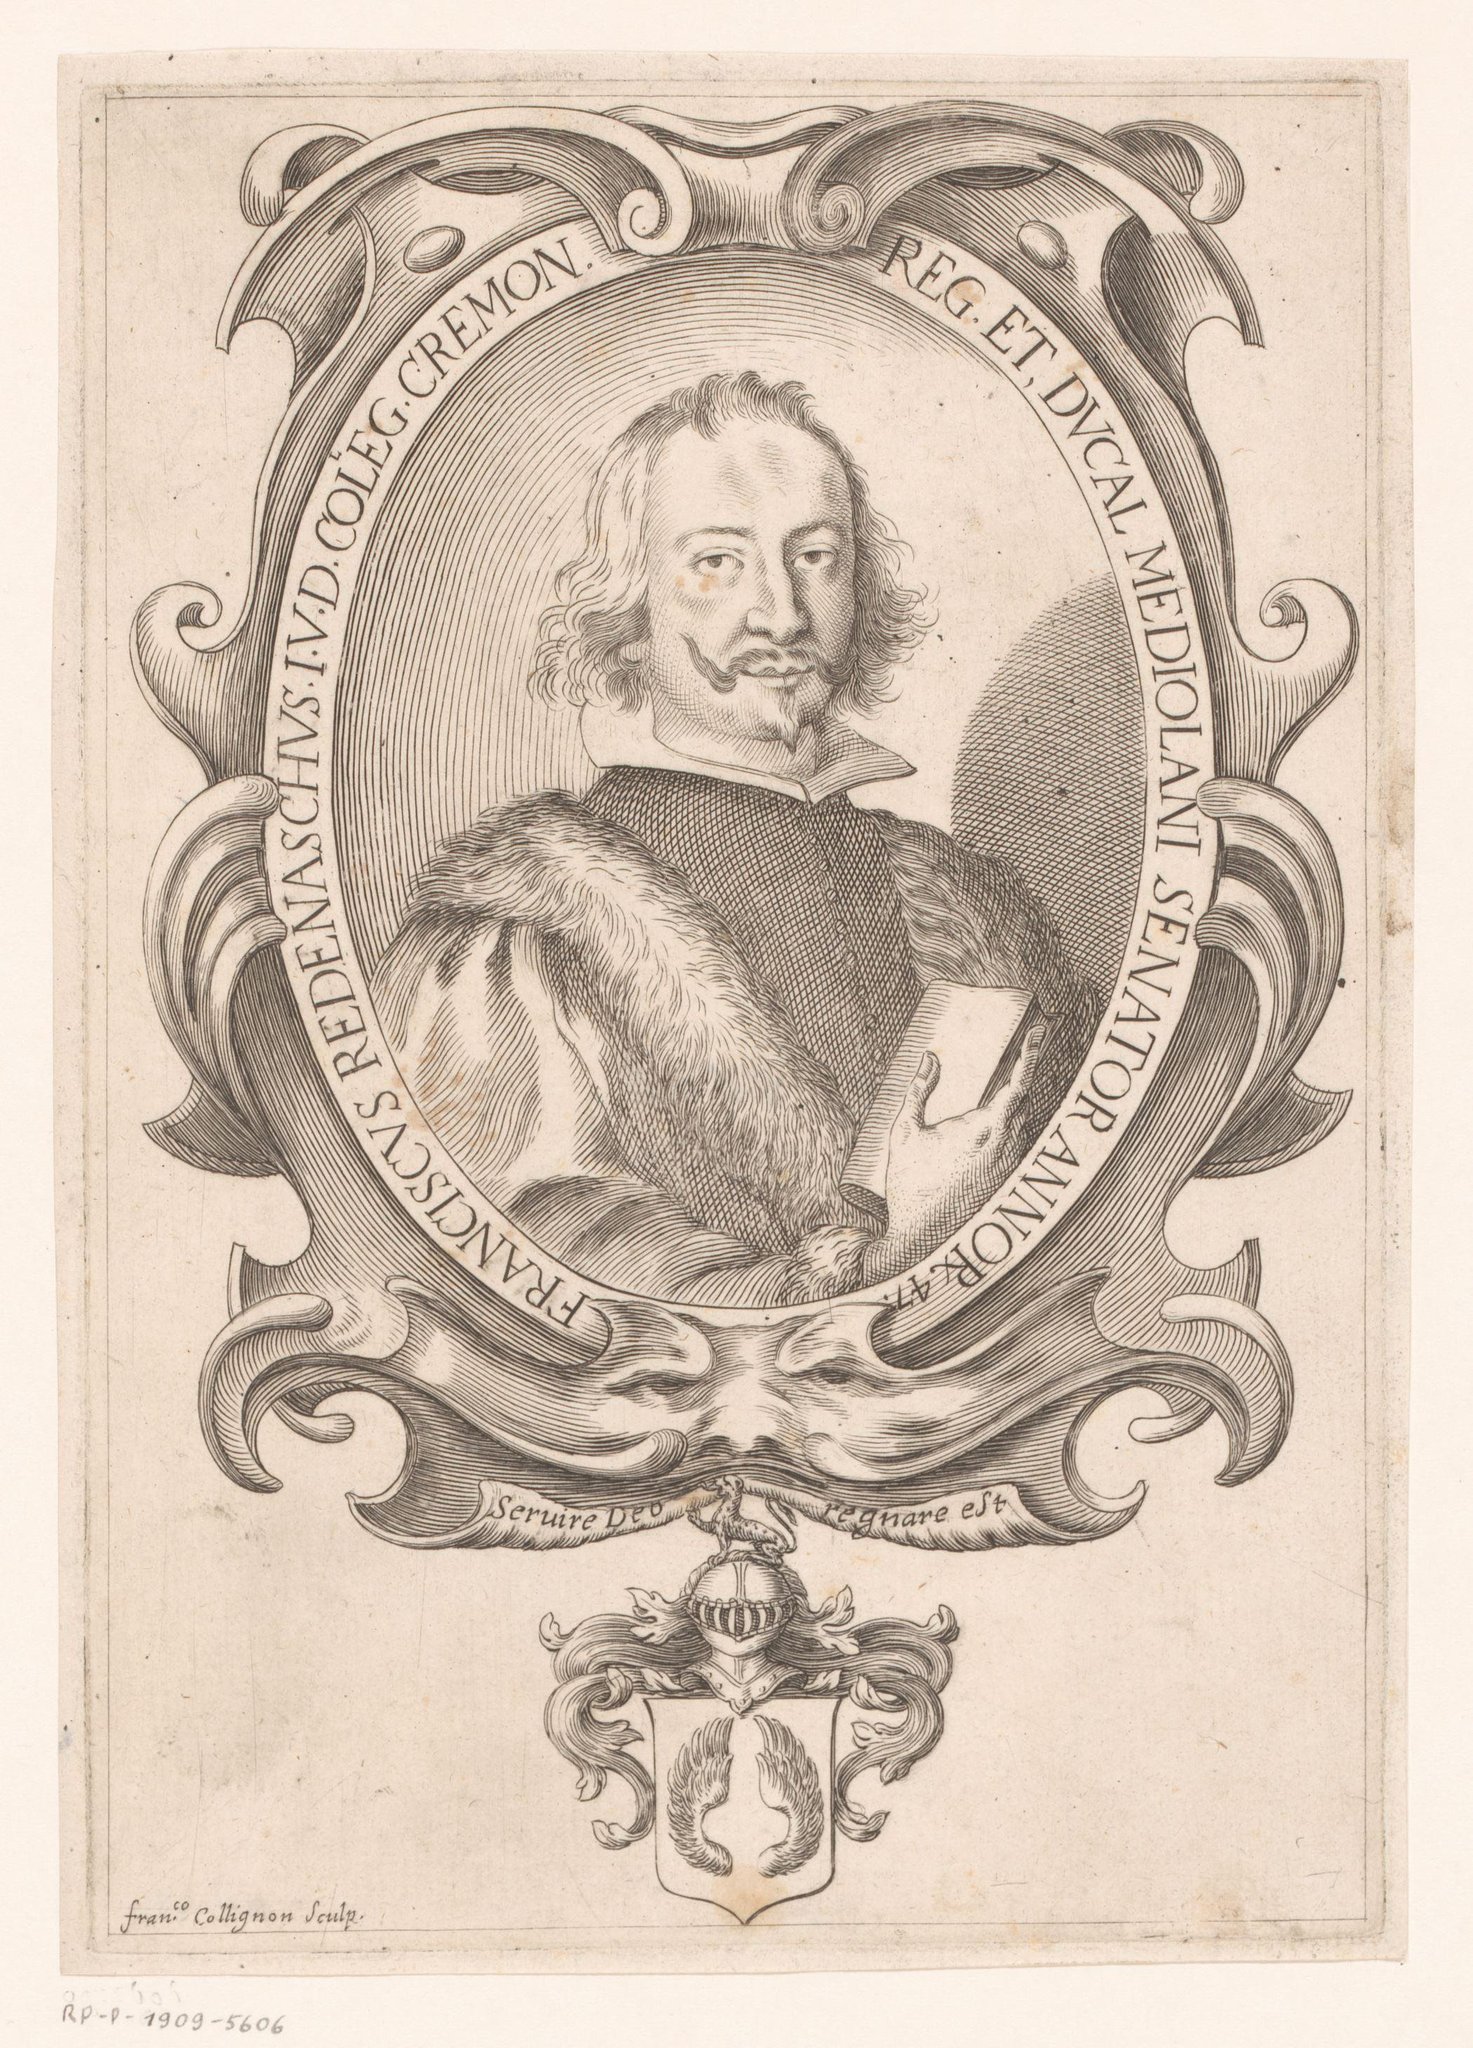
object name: print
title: Portret van Franciscus Redenaschus op 47-jarige leeftijd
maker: françois collignon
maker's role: print maker, publisher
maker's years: 1610-1687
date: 1620-1687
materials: paper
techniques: engraving, etching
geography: france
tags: historical persons, armorial bearing, heraldry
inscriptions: collector's mark: Lugt 2228